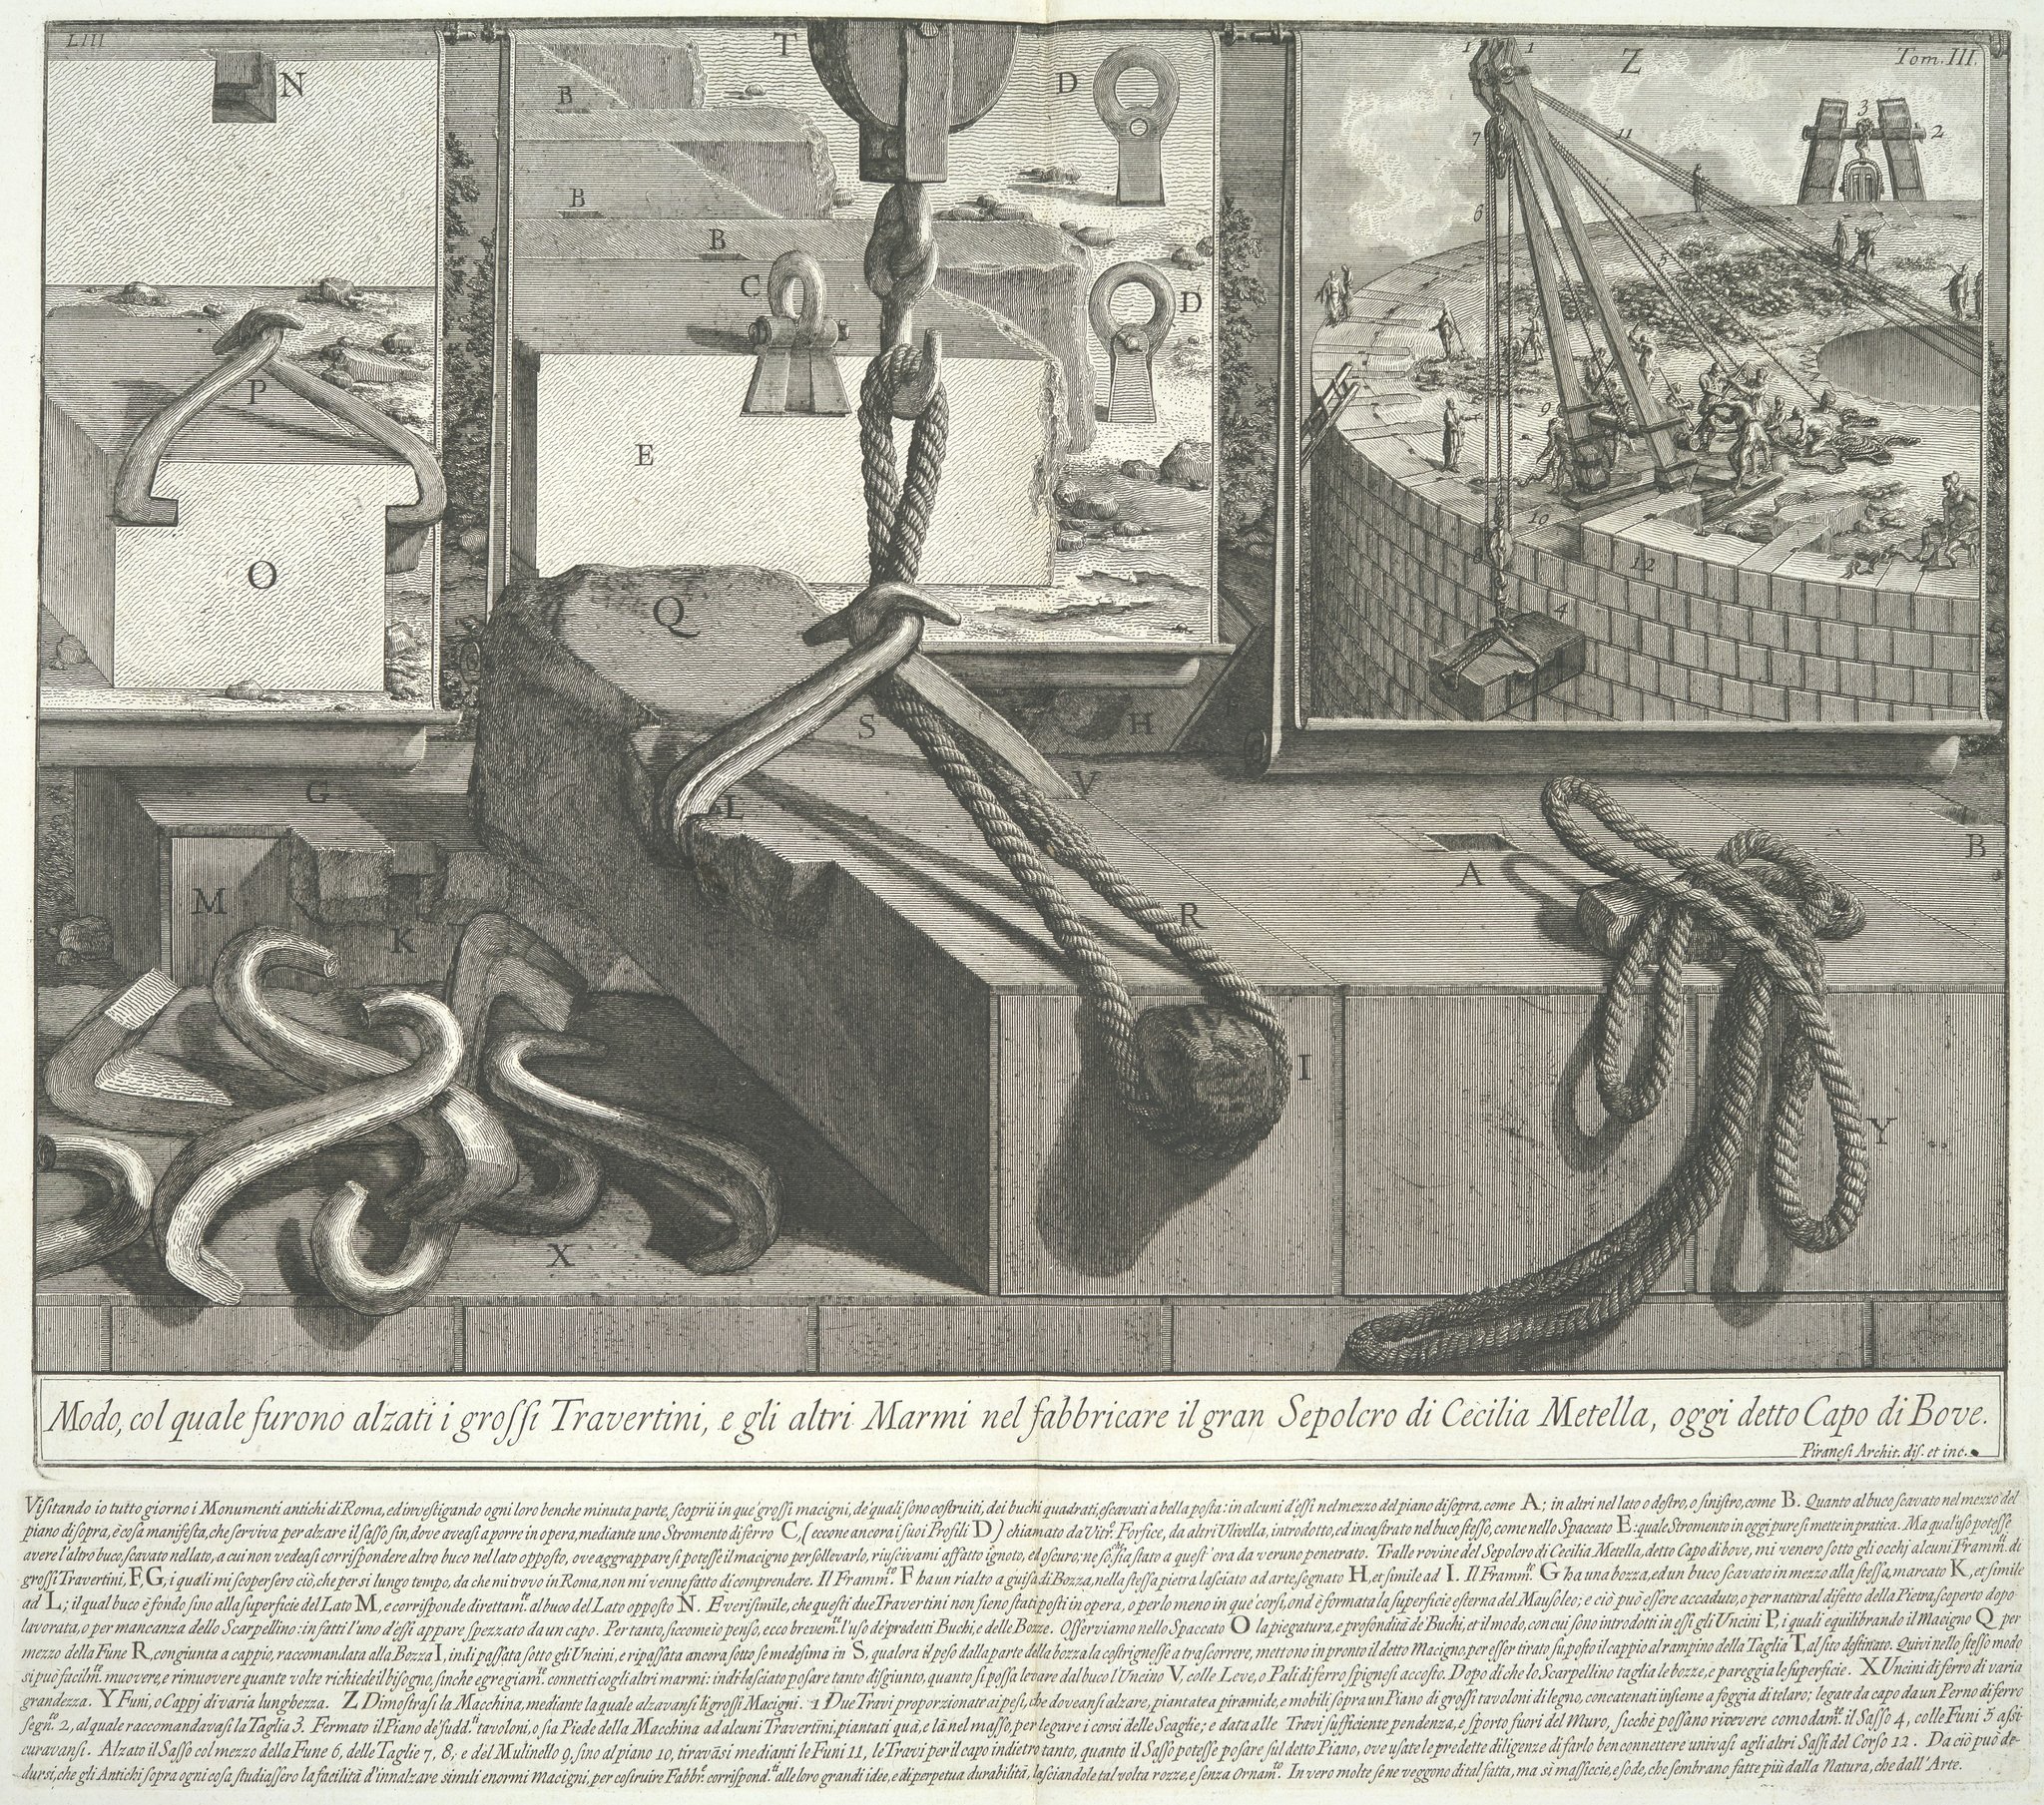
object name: album print ornament architecture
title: Means by which the large blocks of travertine and marble were lifted during the construction of the large Tomb of Caecilia Metella, tome 3, tavola 53 from "Le Antichità Romane" (Roman Antiquities)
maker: giovanni battista piranesi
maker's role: artist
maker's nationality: italian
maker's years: 1720-1778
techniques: etching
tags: architecture,tombs,rome